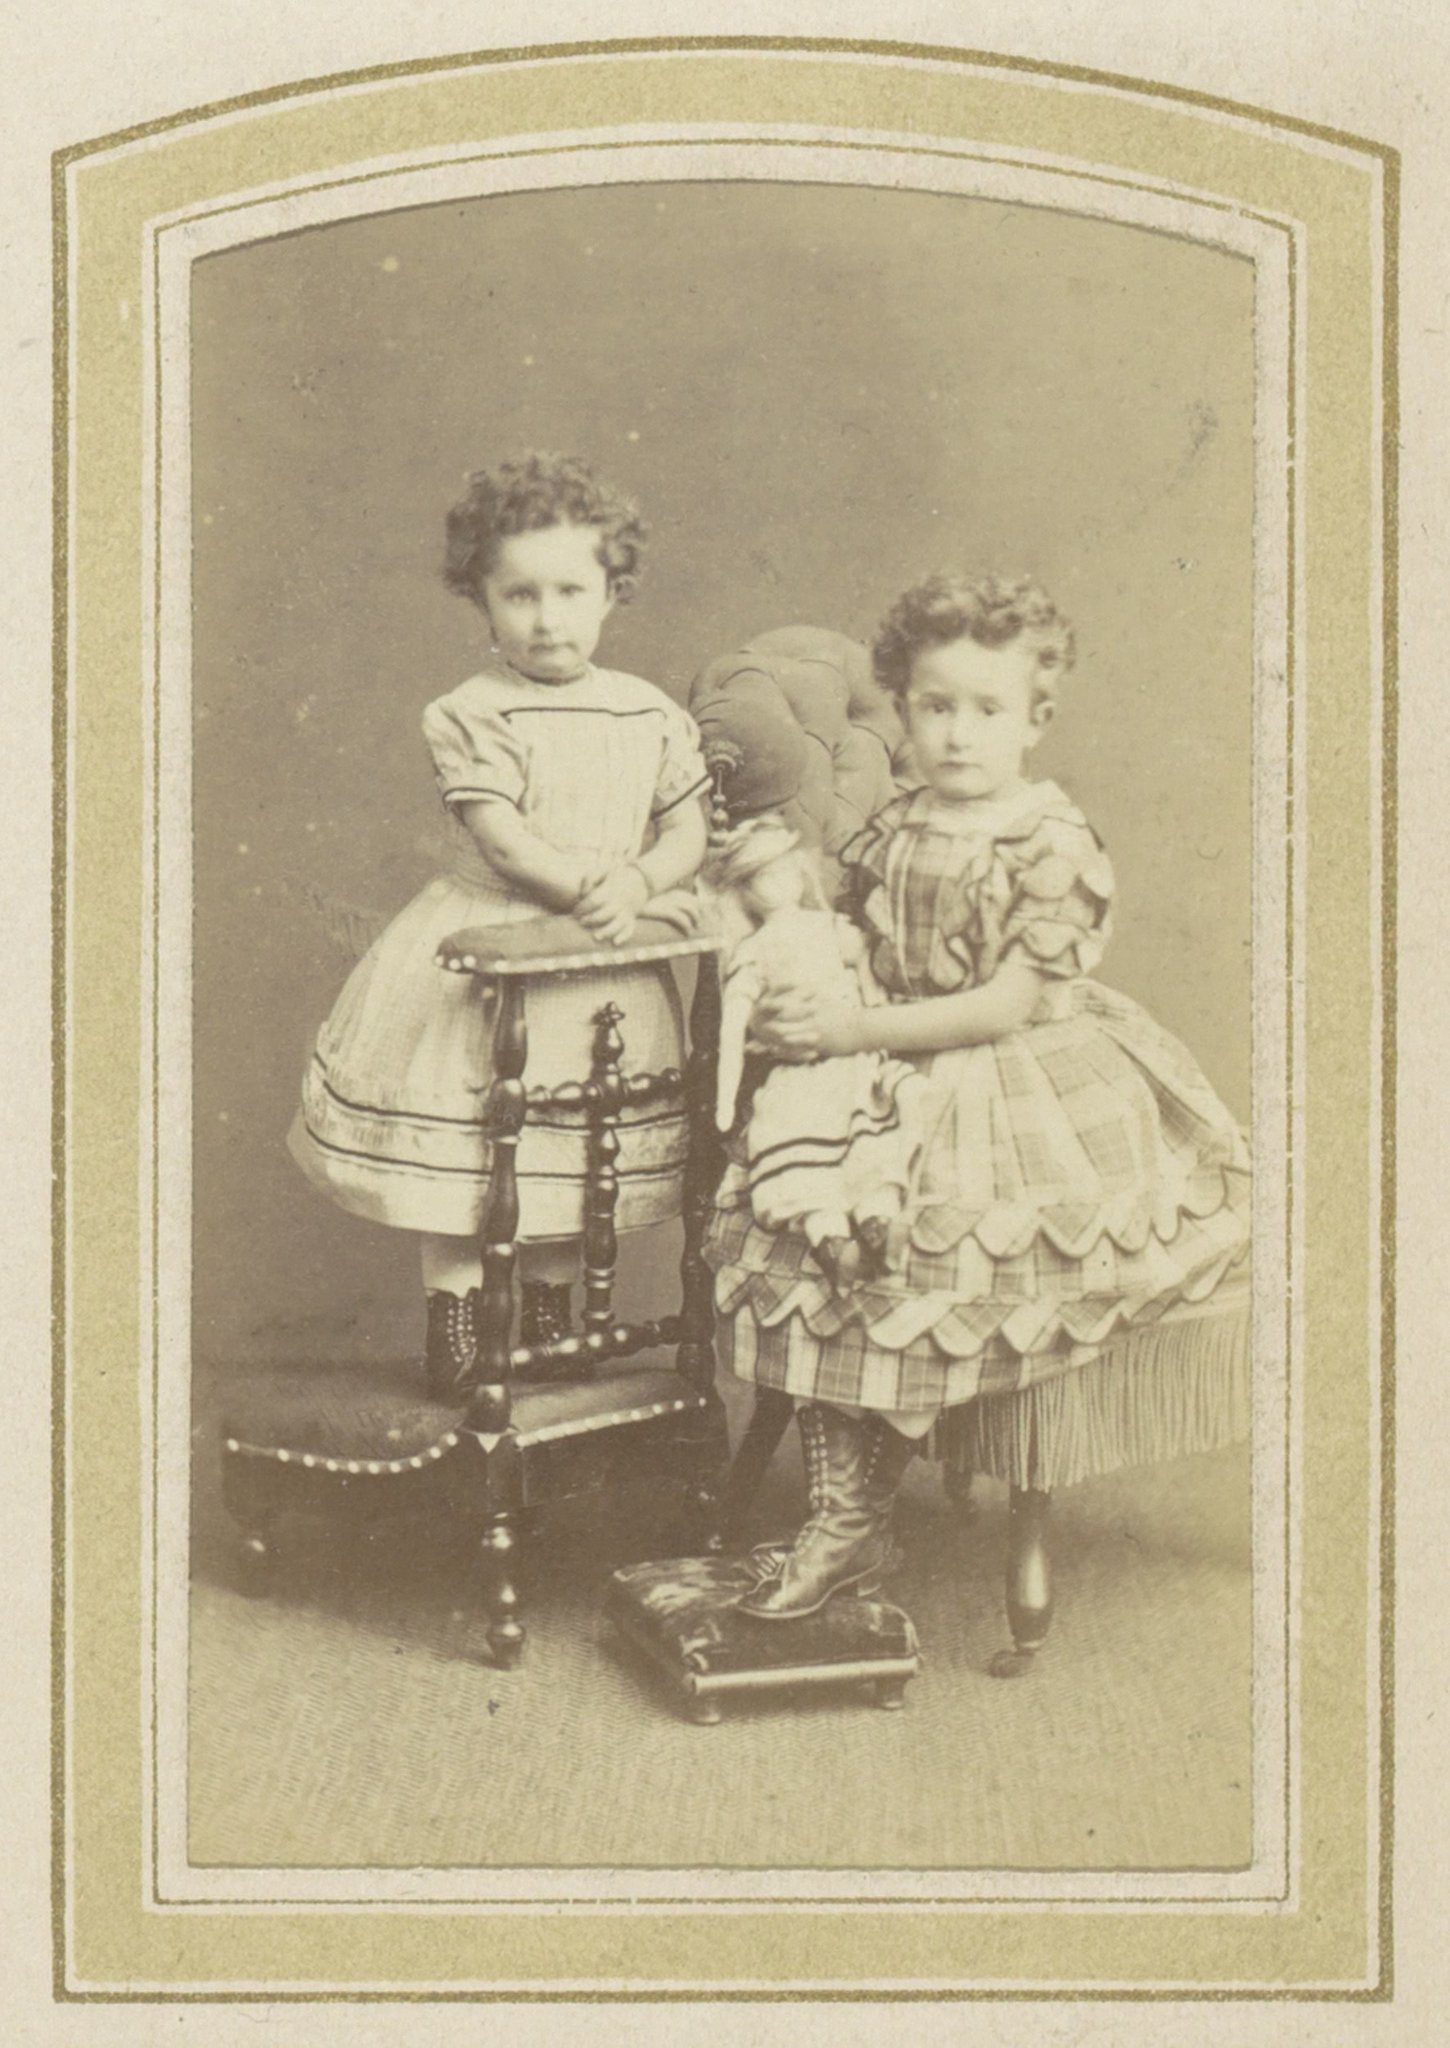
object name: carte de visite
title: Portret van een twee meisjes in jurken met een pop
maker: albert greiner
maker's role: fotograaf, fotostudio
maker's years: 1833-1890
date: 1862-1900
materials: cardboard, paper, photographic support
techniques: albumen print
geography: amsterdam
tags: studio requisites ~ photographer, child, historical persons, (playing with) dolls, dress, gown, amsterdam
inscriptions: address: ‘Amsterdam’, address: ‘Nieuwendijk L.87 Amsterdam’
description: Onderdeel van Fotoalbum van een Nederlandse familie met 168 cartes-de-visite en kabinetfoto's.